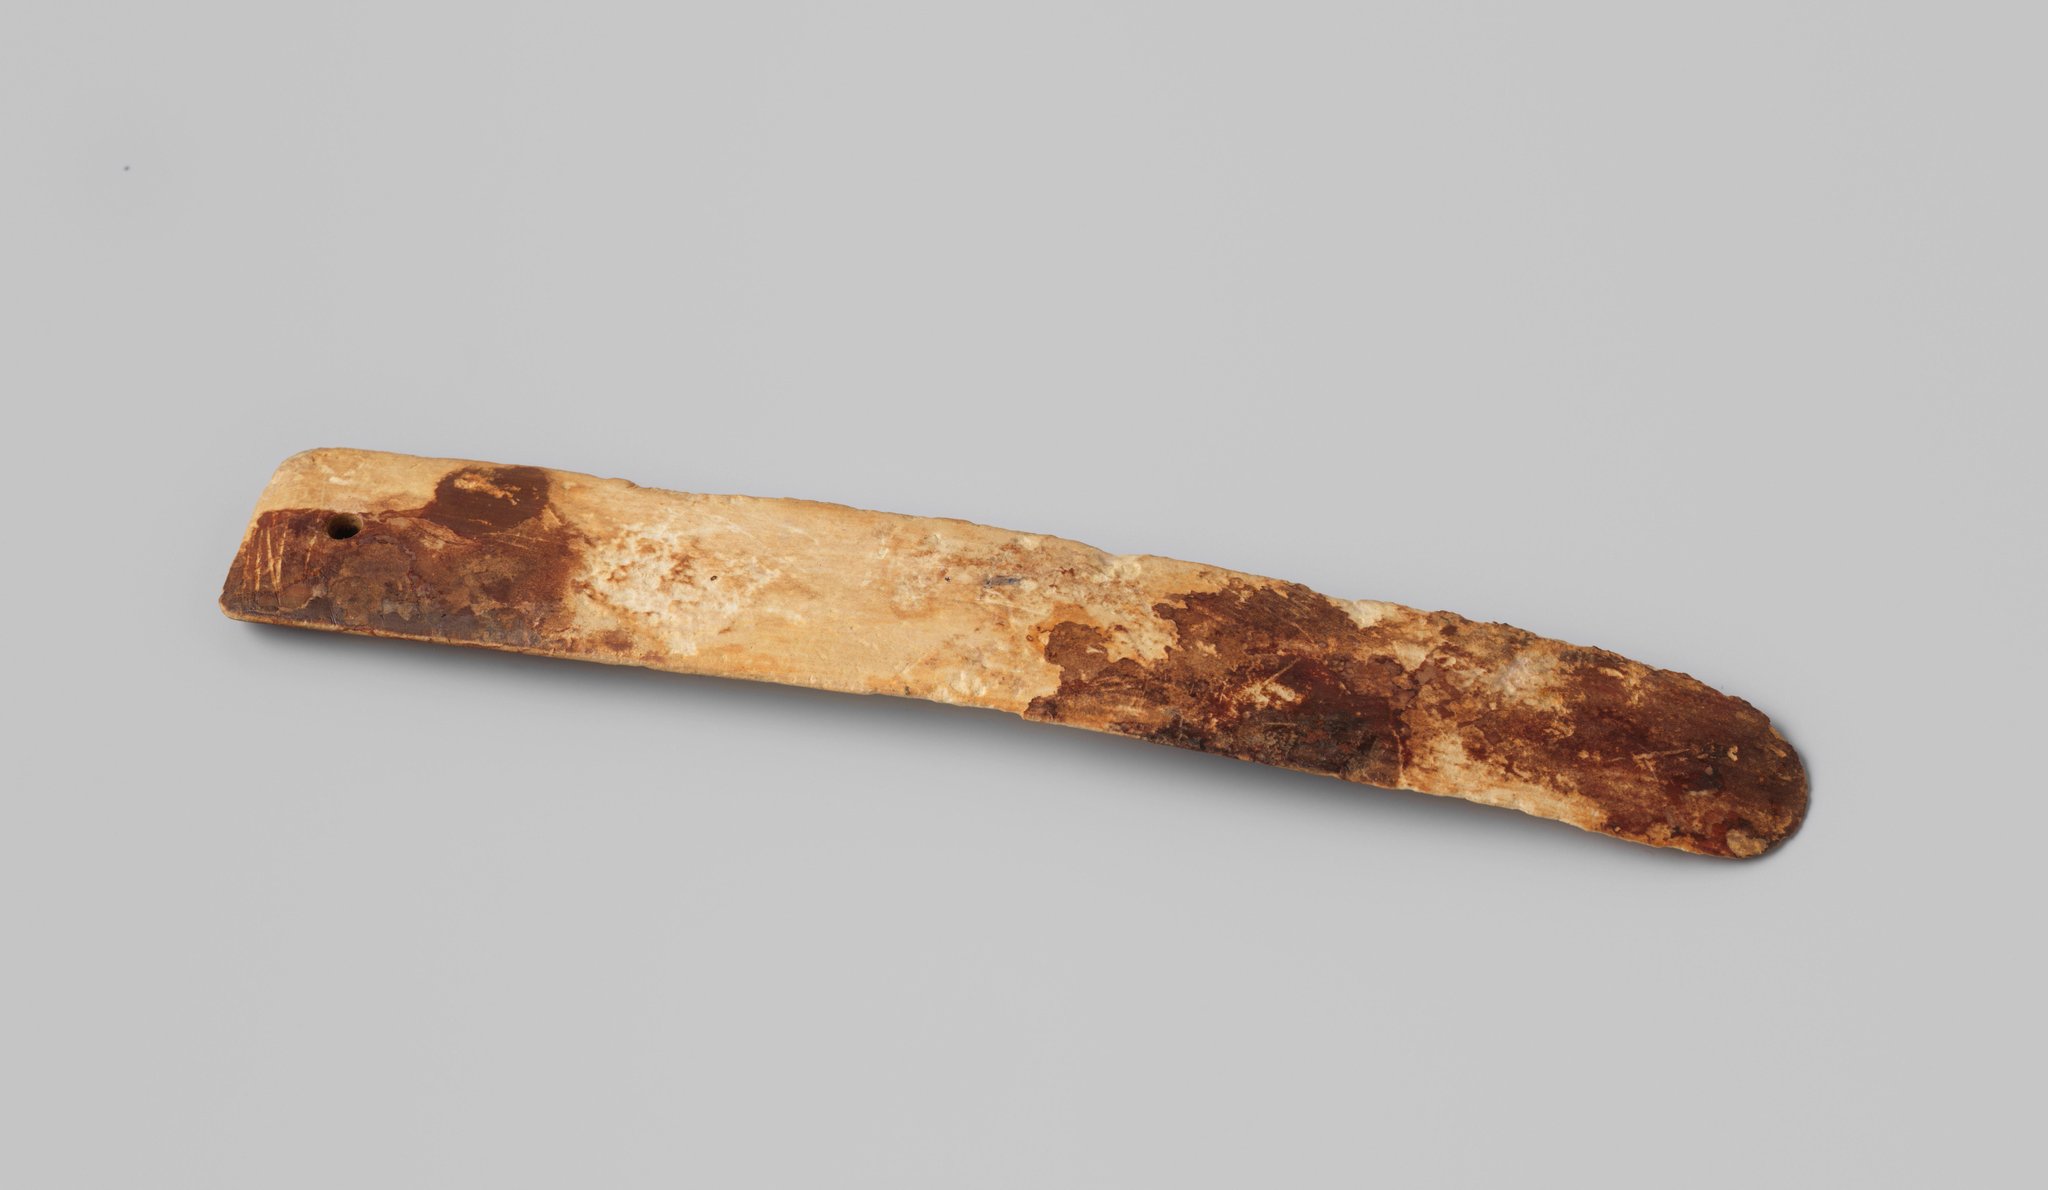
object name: knife tool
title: Bone paper knife from the wreck of the Dutch East India ship Hollandia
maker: Anonymous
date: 1700-1743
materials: bone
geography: netherlands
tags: verenigde oostindische compagnie, hollandia (schip), annet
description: Knife, straight strip, slightly curved, rear end rectangular, faceted, pierced, other end semicircular, tapering, narrowing, lens-shaped in section.